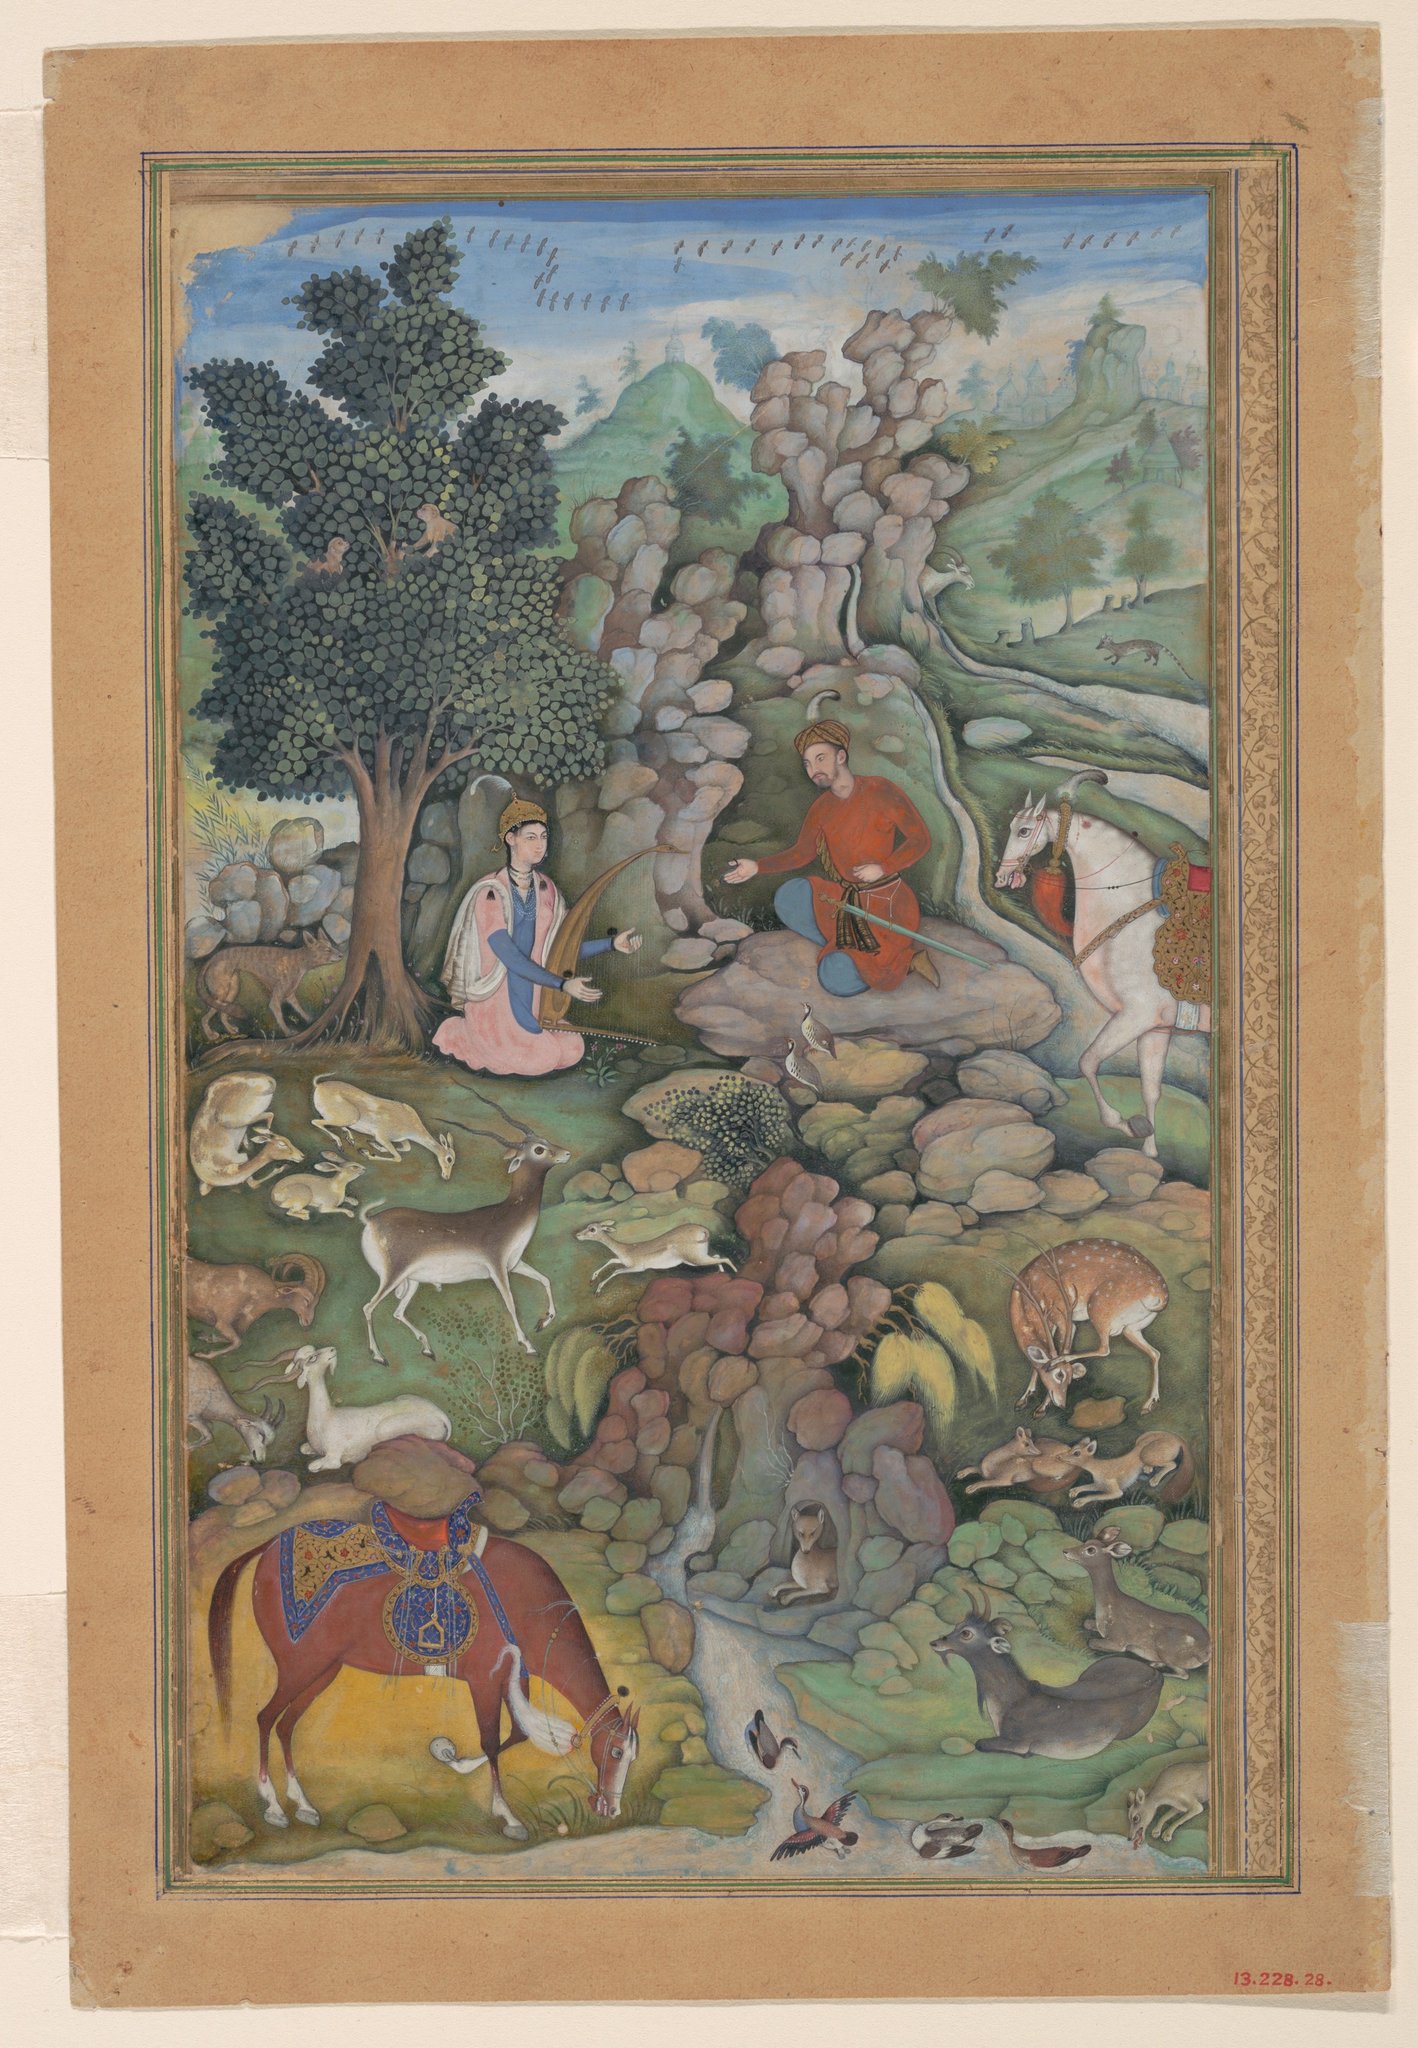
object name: folio from an illustrated manuscript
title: "Bahram Gur Sees a Herd of Deer Mesmerized by Dilaram' s Music", Folio from a Khamsa (Quintet) of Amir Khusrau Dihlavi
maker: amir khusrau dihlavi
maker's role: author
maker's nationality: indian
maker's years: 1228-1350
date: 1597-1598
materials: gold, ink, paper, watercolor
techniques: dyeing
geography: india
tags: men,women,harps,deer,horses,rabbits